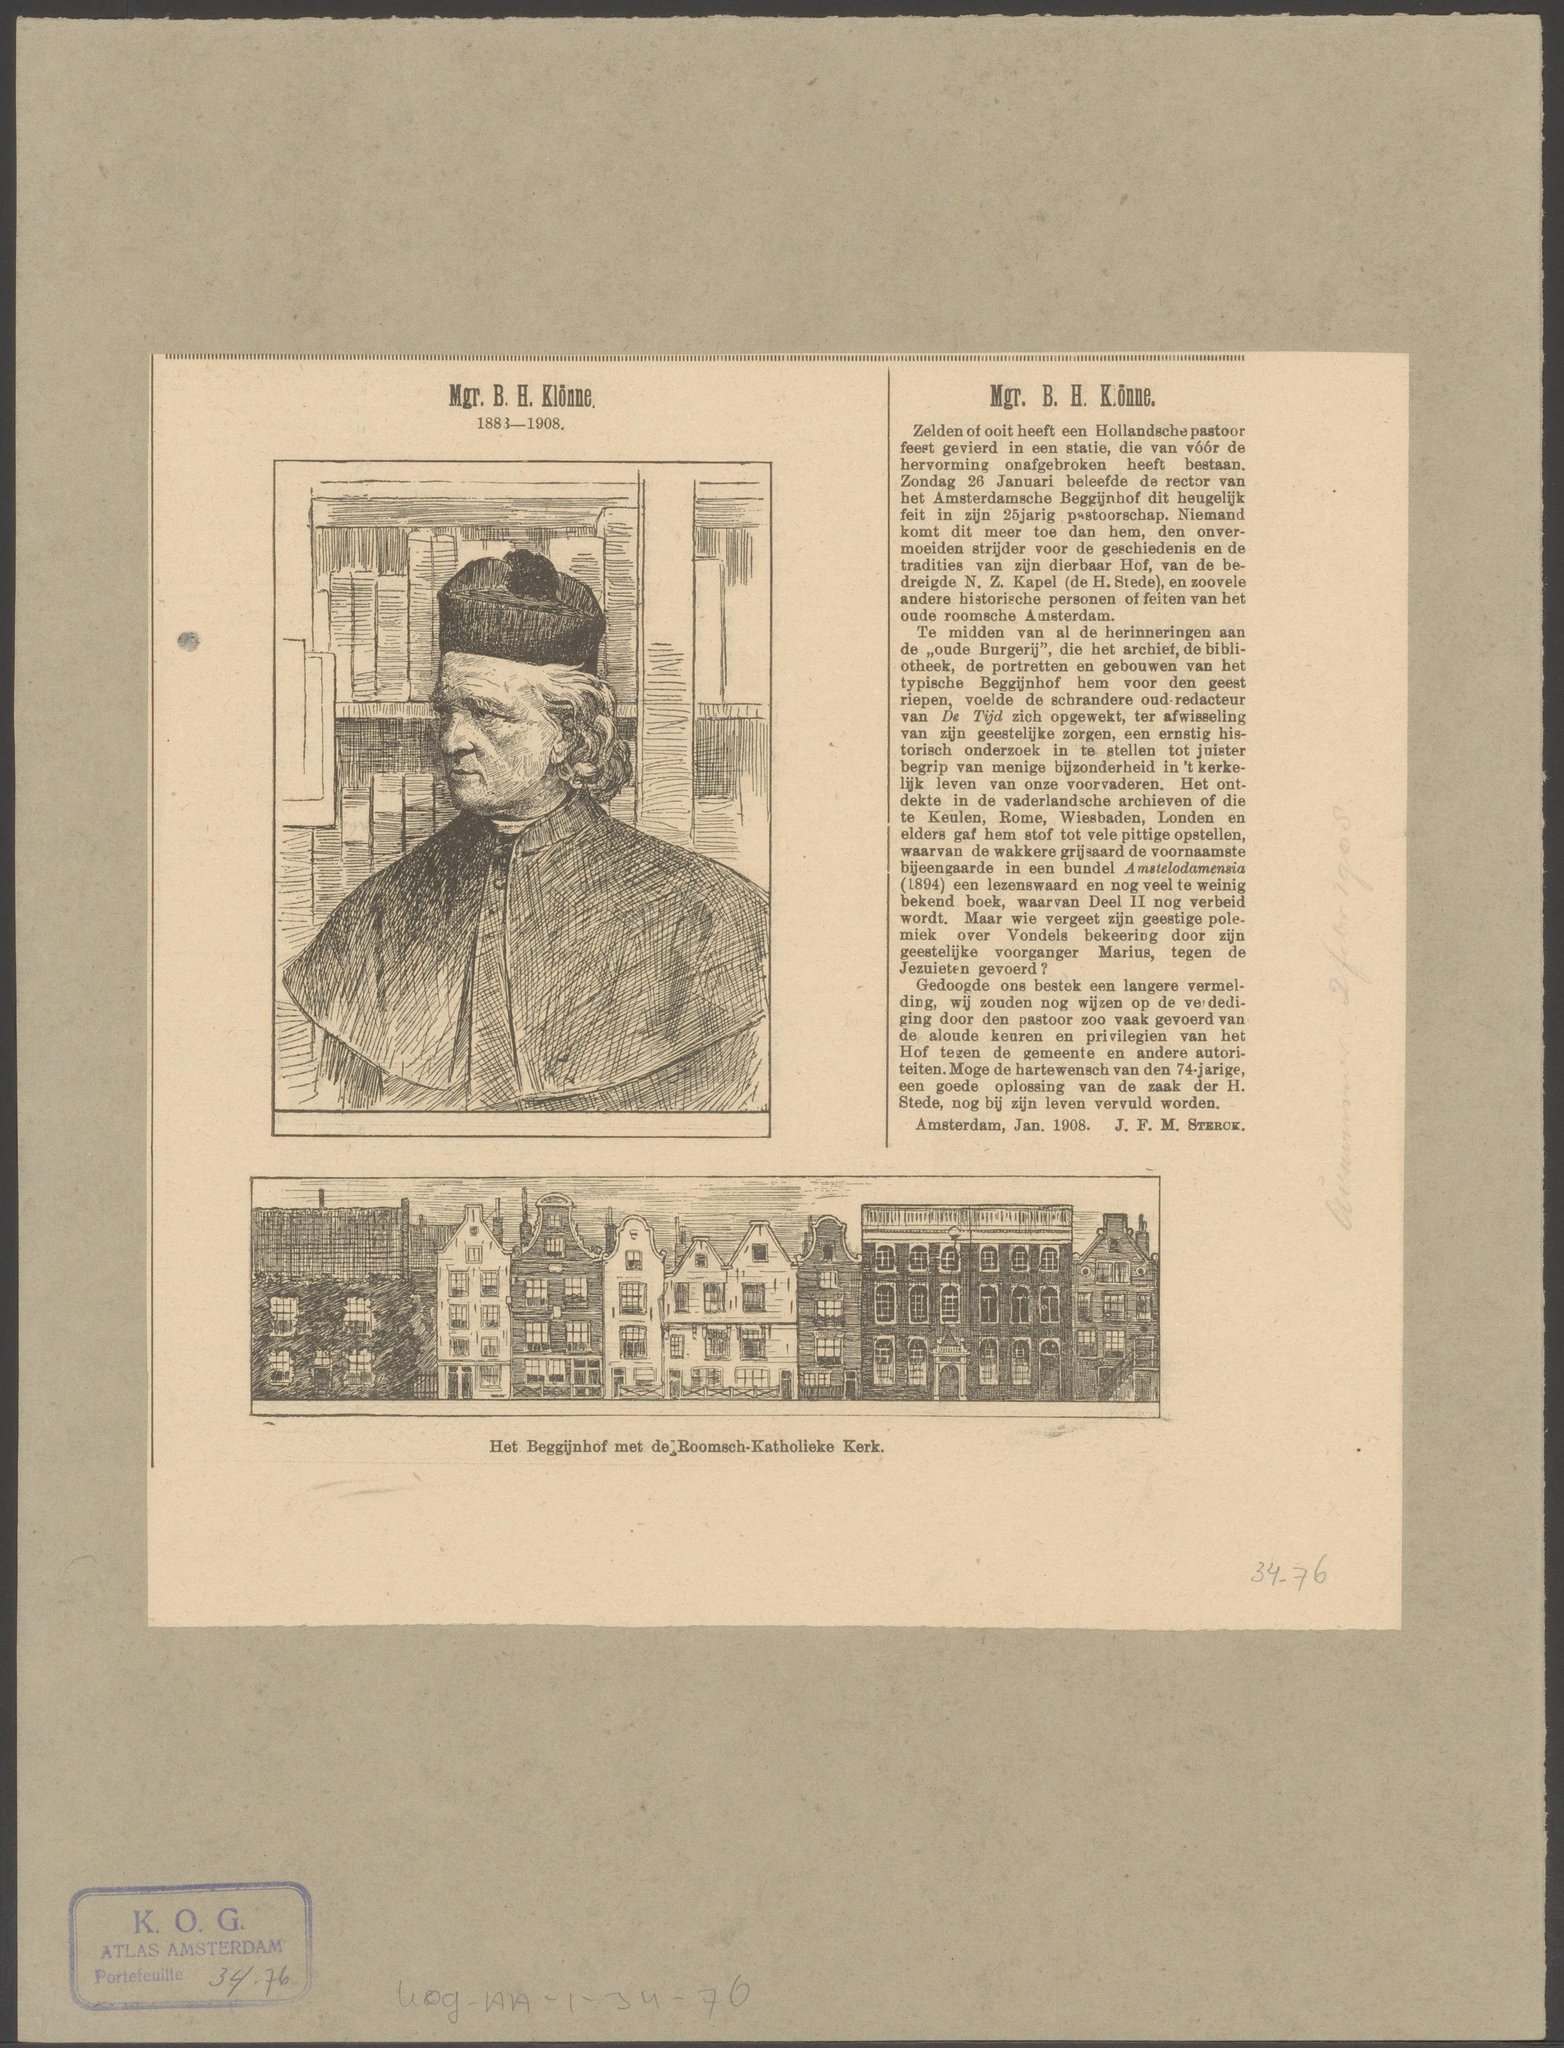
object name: photomechanical print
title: Portret van Bernardus Henricus Klönne en gezicht op het Begijnhof te Amsterdam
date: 1908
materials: paper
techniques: letterpress printing, line block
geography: amsterdam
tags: amsterdam, designer, bernardus henricus klönne, city-view, and landscape with man-made constructions, historical persons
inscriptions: collector's mark: Lugt 1641b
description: Onderwerpsrubriek binnen de Atlas Amsterdam: Kerkwezen: R.K. Gemeenten: Begijnhof t/m Petrus en Paulus.